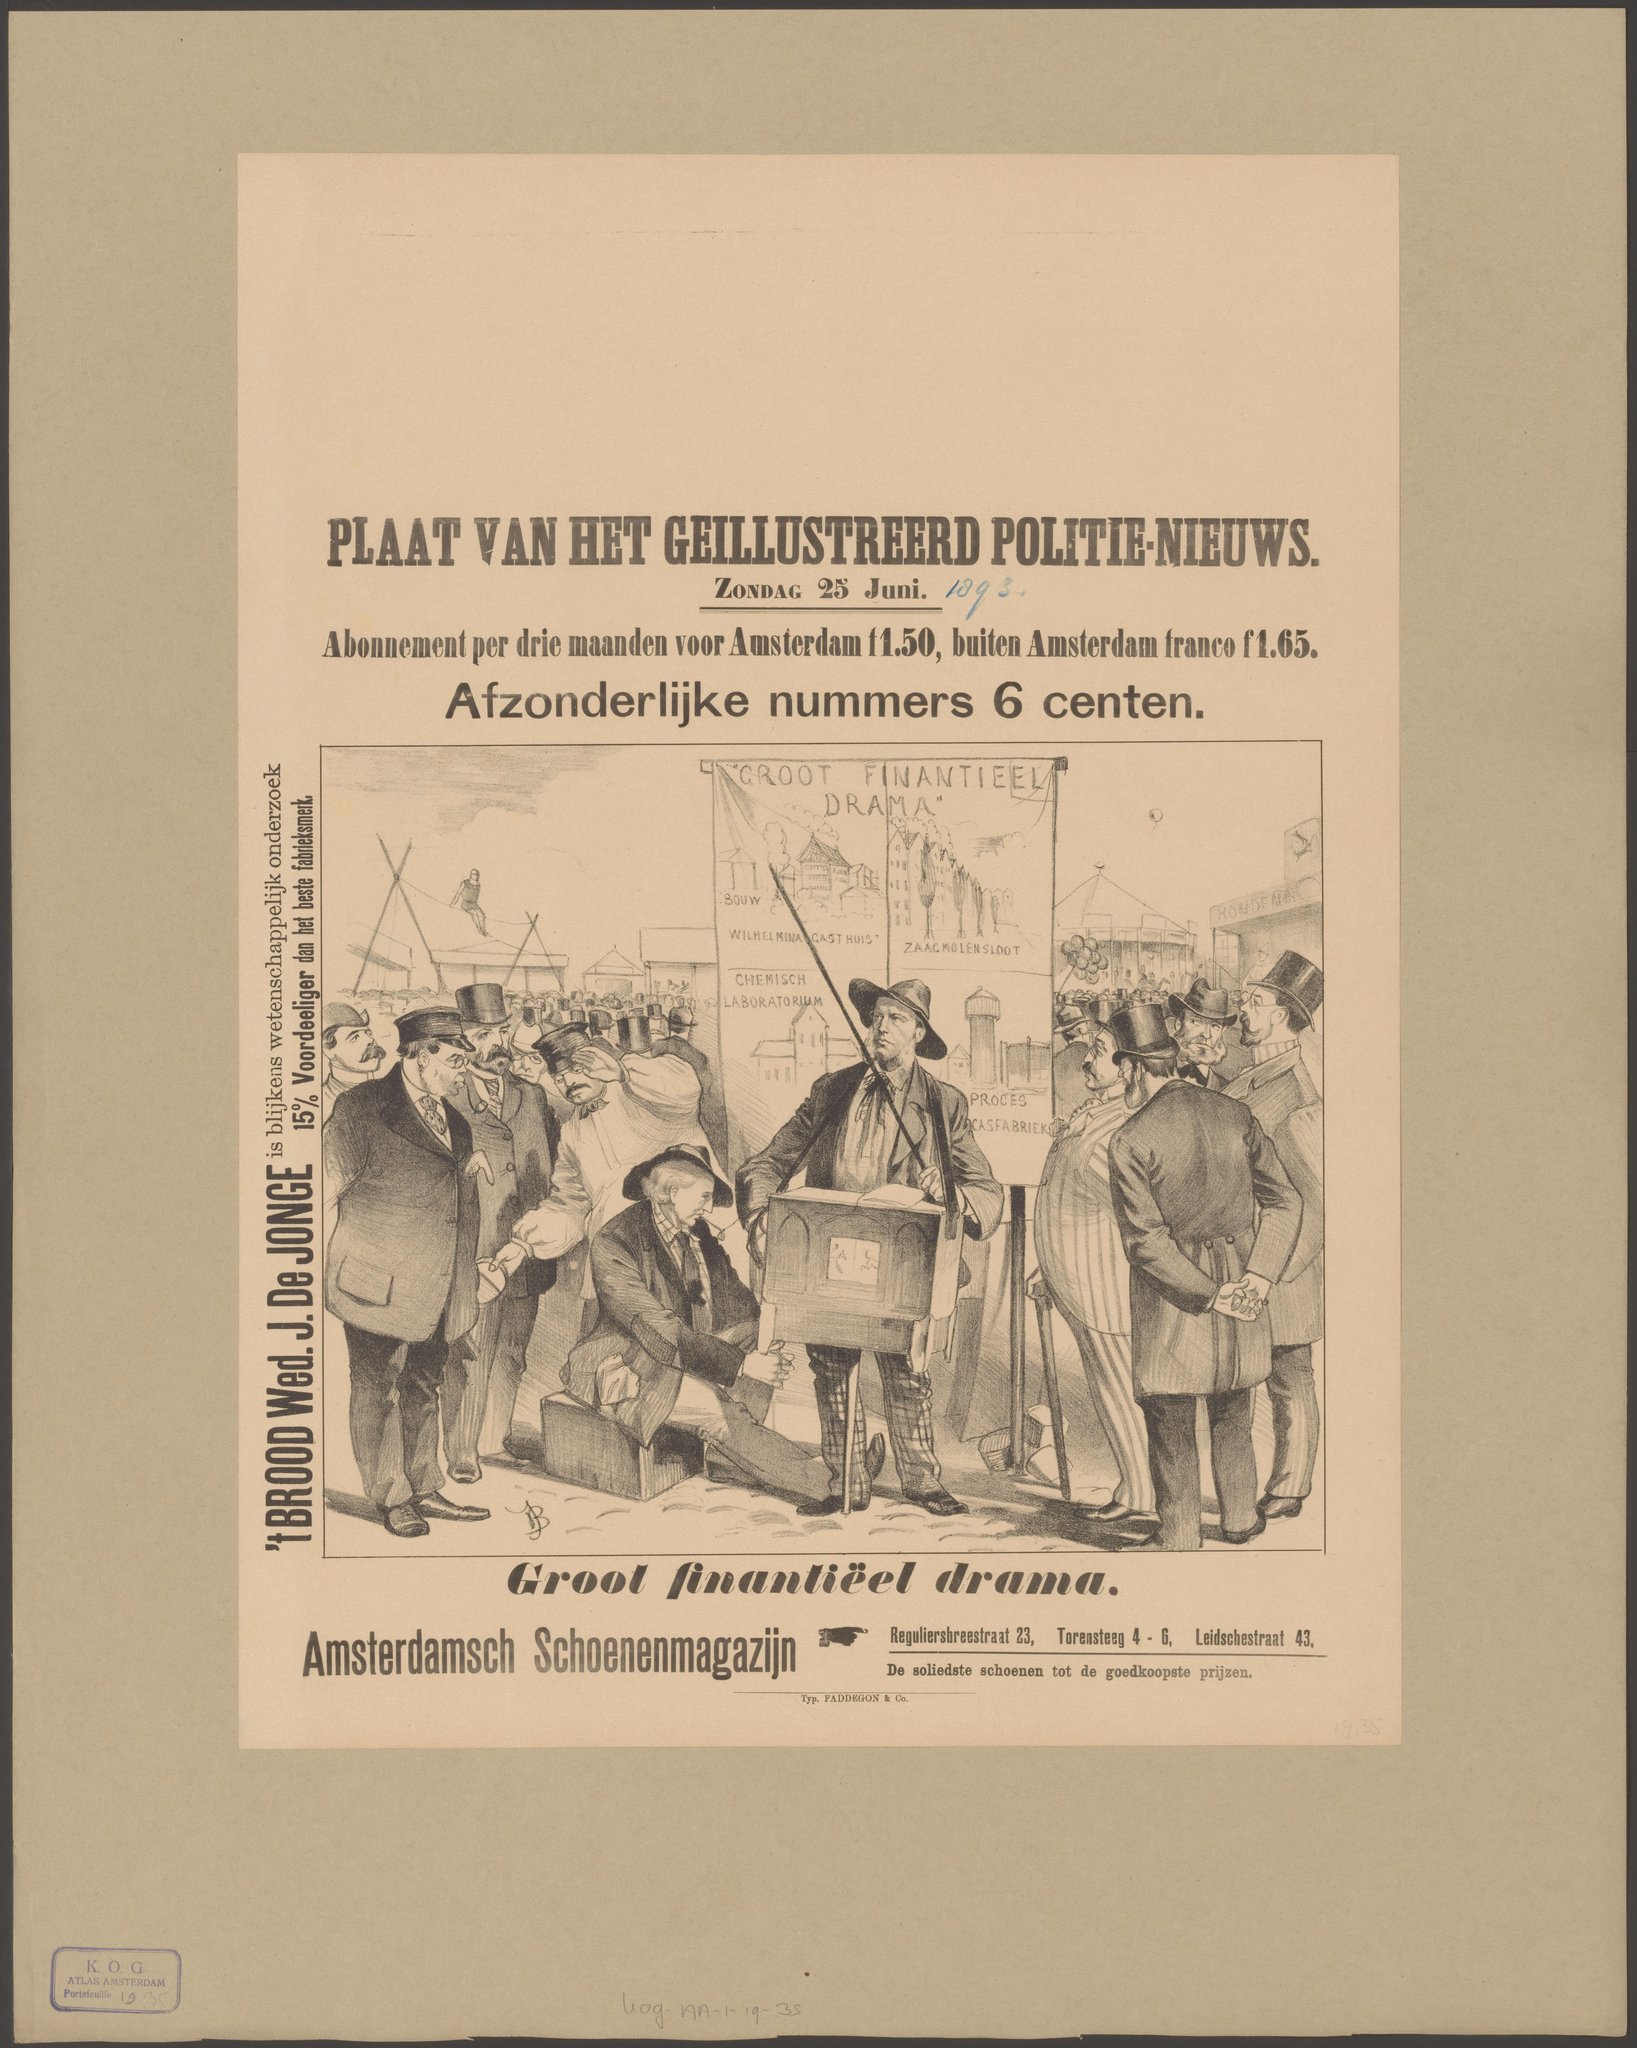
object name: cartoon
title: Spotprent op de gemeentelijke uitgaven van 1893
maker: johan braakensiek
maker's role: draughtsman, print maker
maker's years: 1858-1940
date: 1893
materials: paper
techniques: letterpress printing, lithograph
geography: amsterdam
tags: harlingen, politician, city council, political caricatures and satires, amsterdam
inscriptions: collector's mark: ‘19,35’ Lugt 1641b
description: Onderwerpsrubriek binnen de Atlas Amsterdam: Herinneringen aan regeringsleden en hunne huisgezinnen [na 1800].